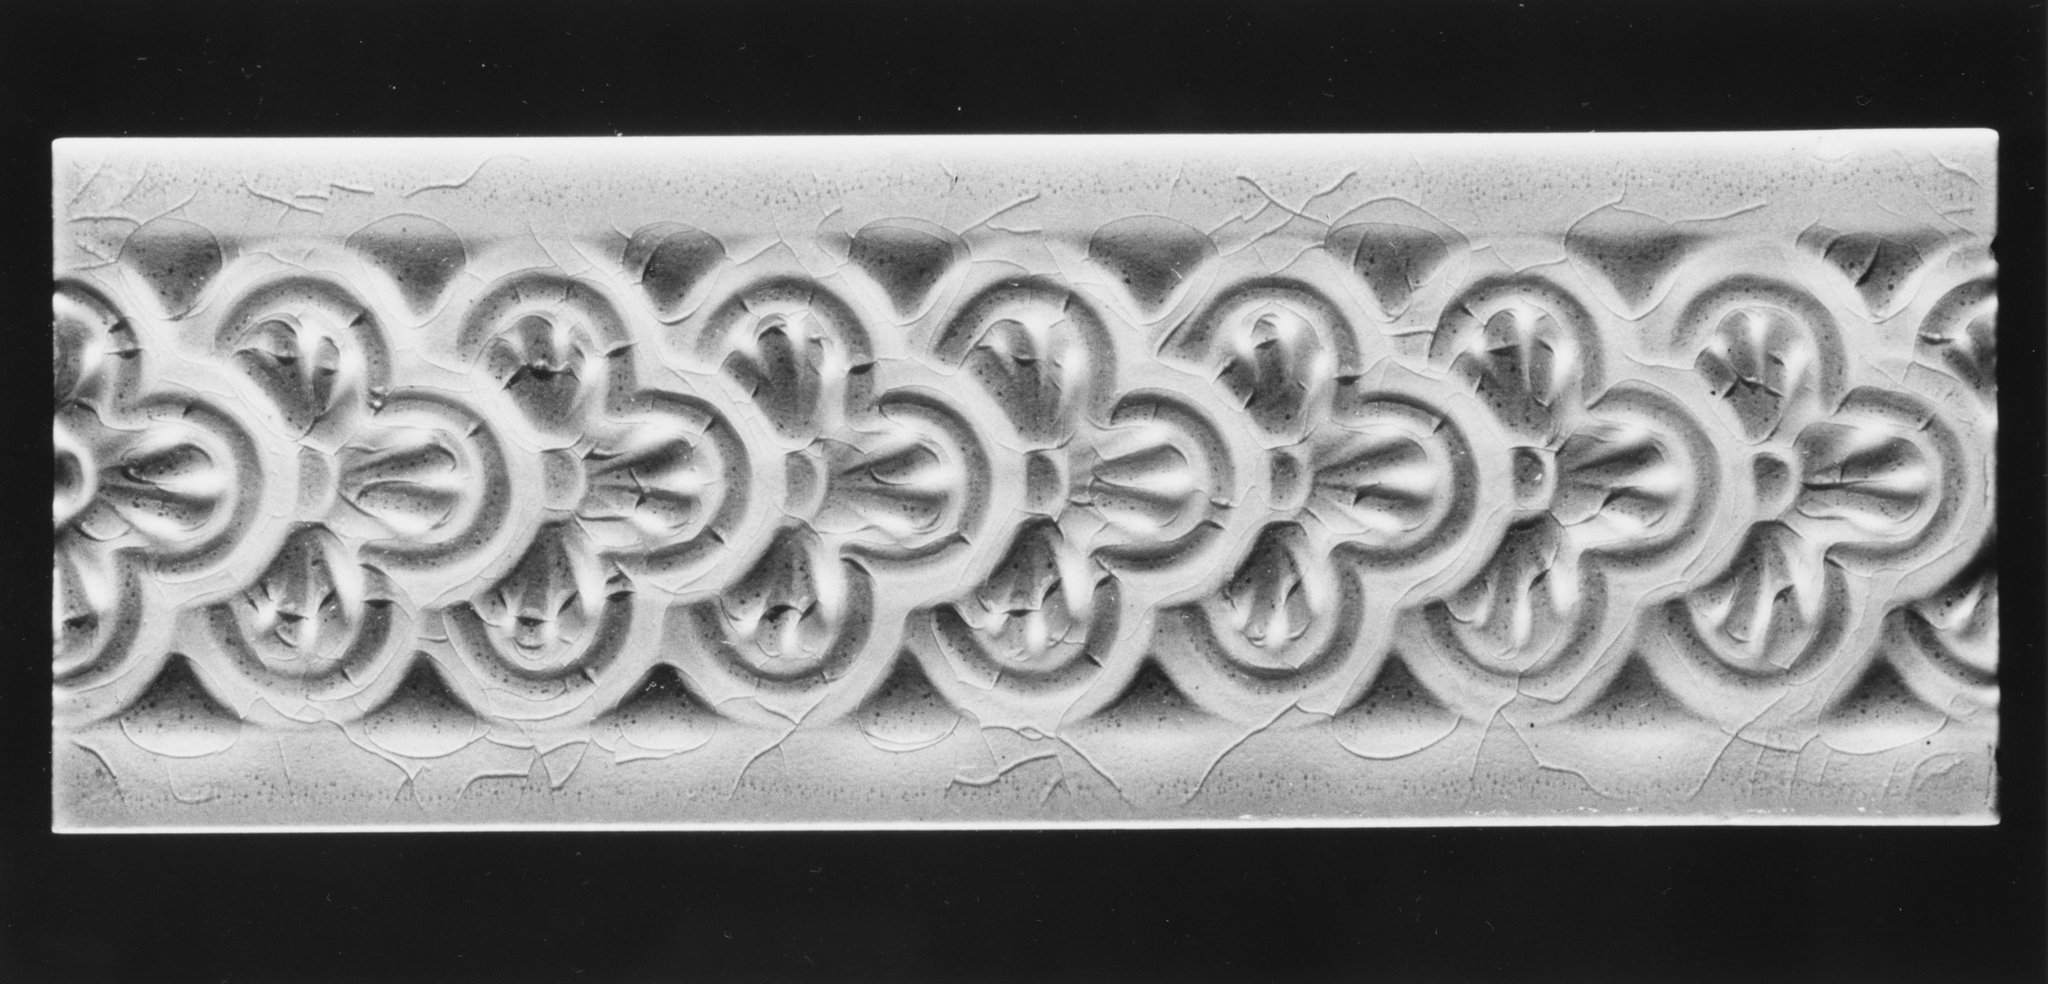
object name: tile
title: Border Tile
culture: american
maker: j. and j. g. low art tile works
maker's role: maker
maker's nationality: american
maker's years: 1877-1903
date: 1881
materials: earthenware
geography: united states